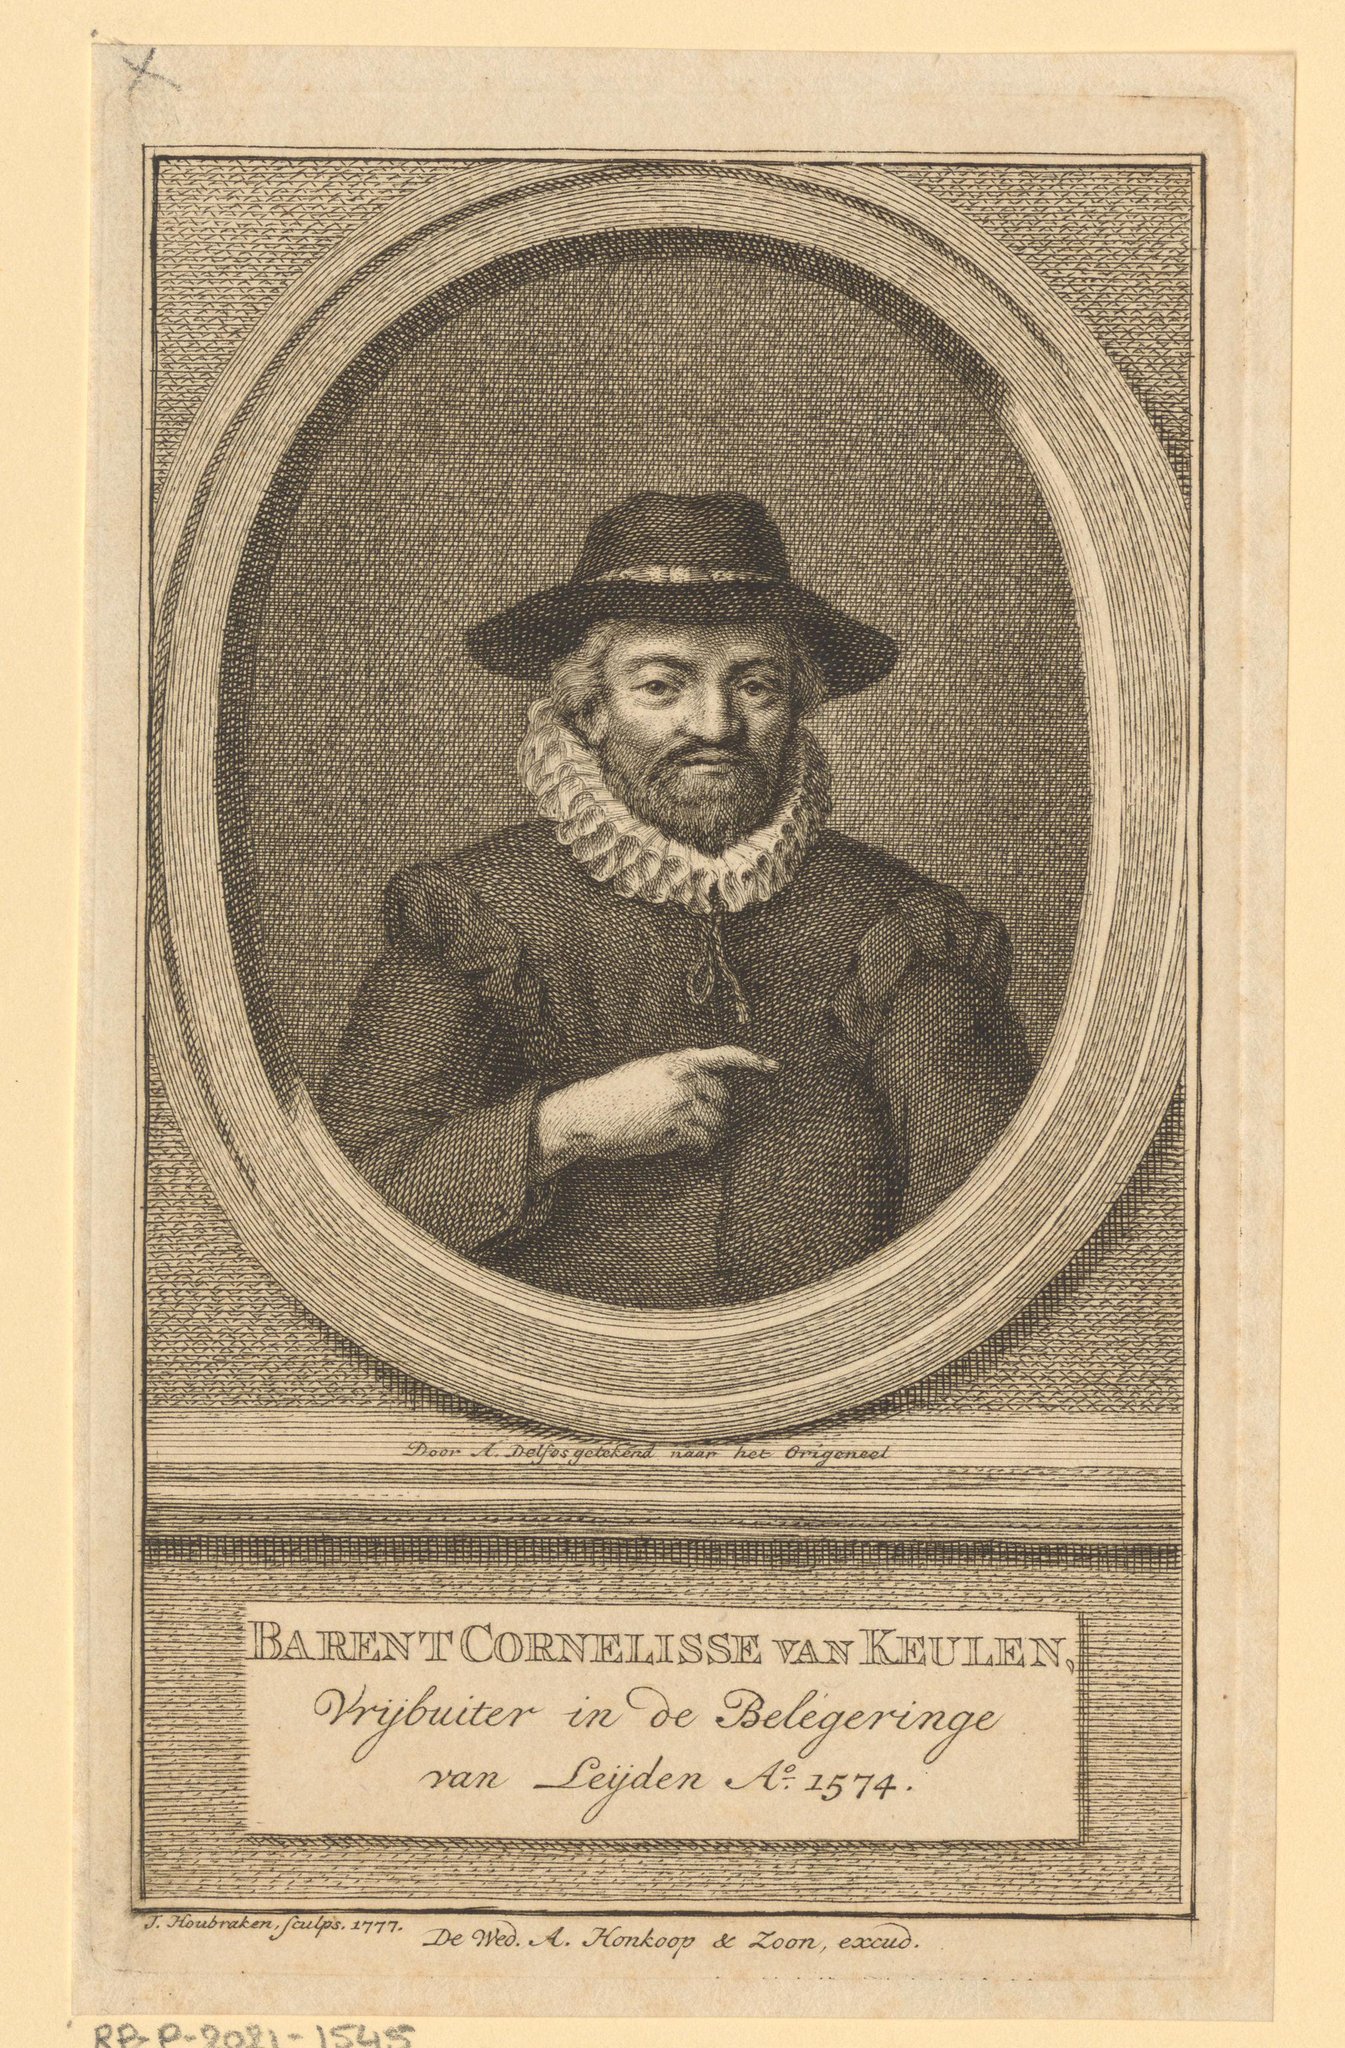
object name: print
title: Portret van Barend Kornelisse van Keulen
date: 1777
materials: paper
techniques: engraving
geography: leiden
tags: historical persons, head-gear: hat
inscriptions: date